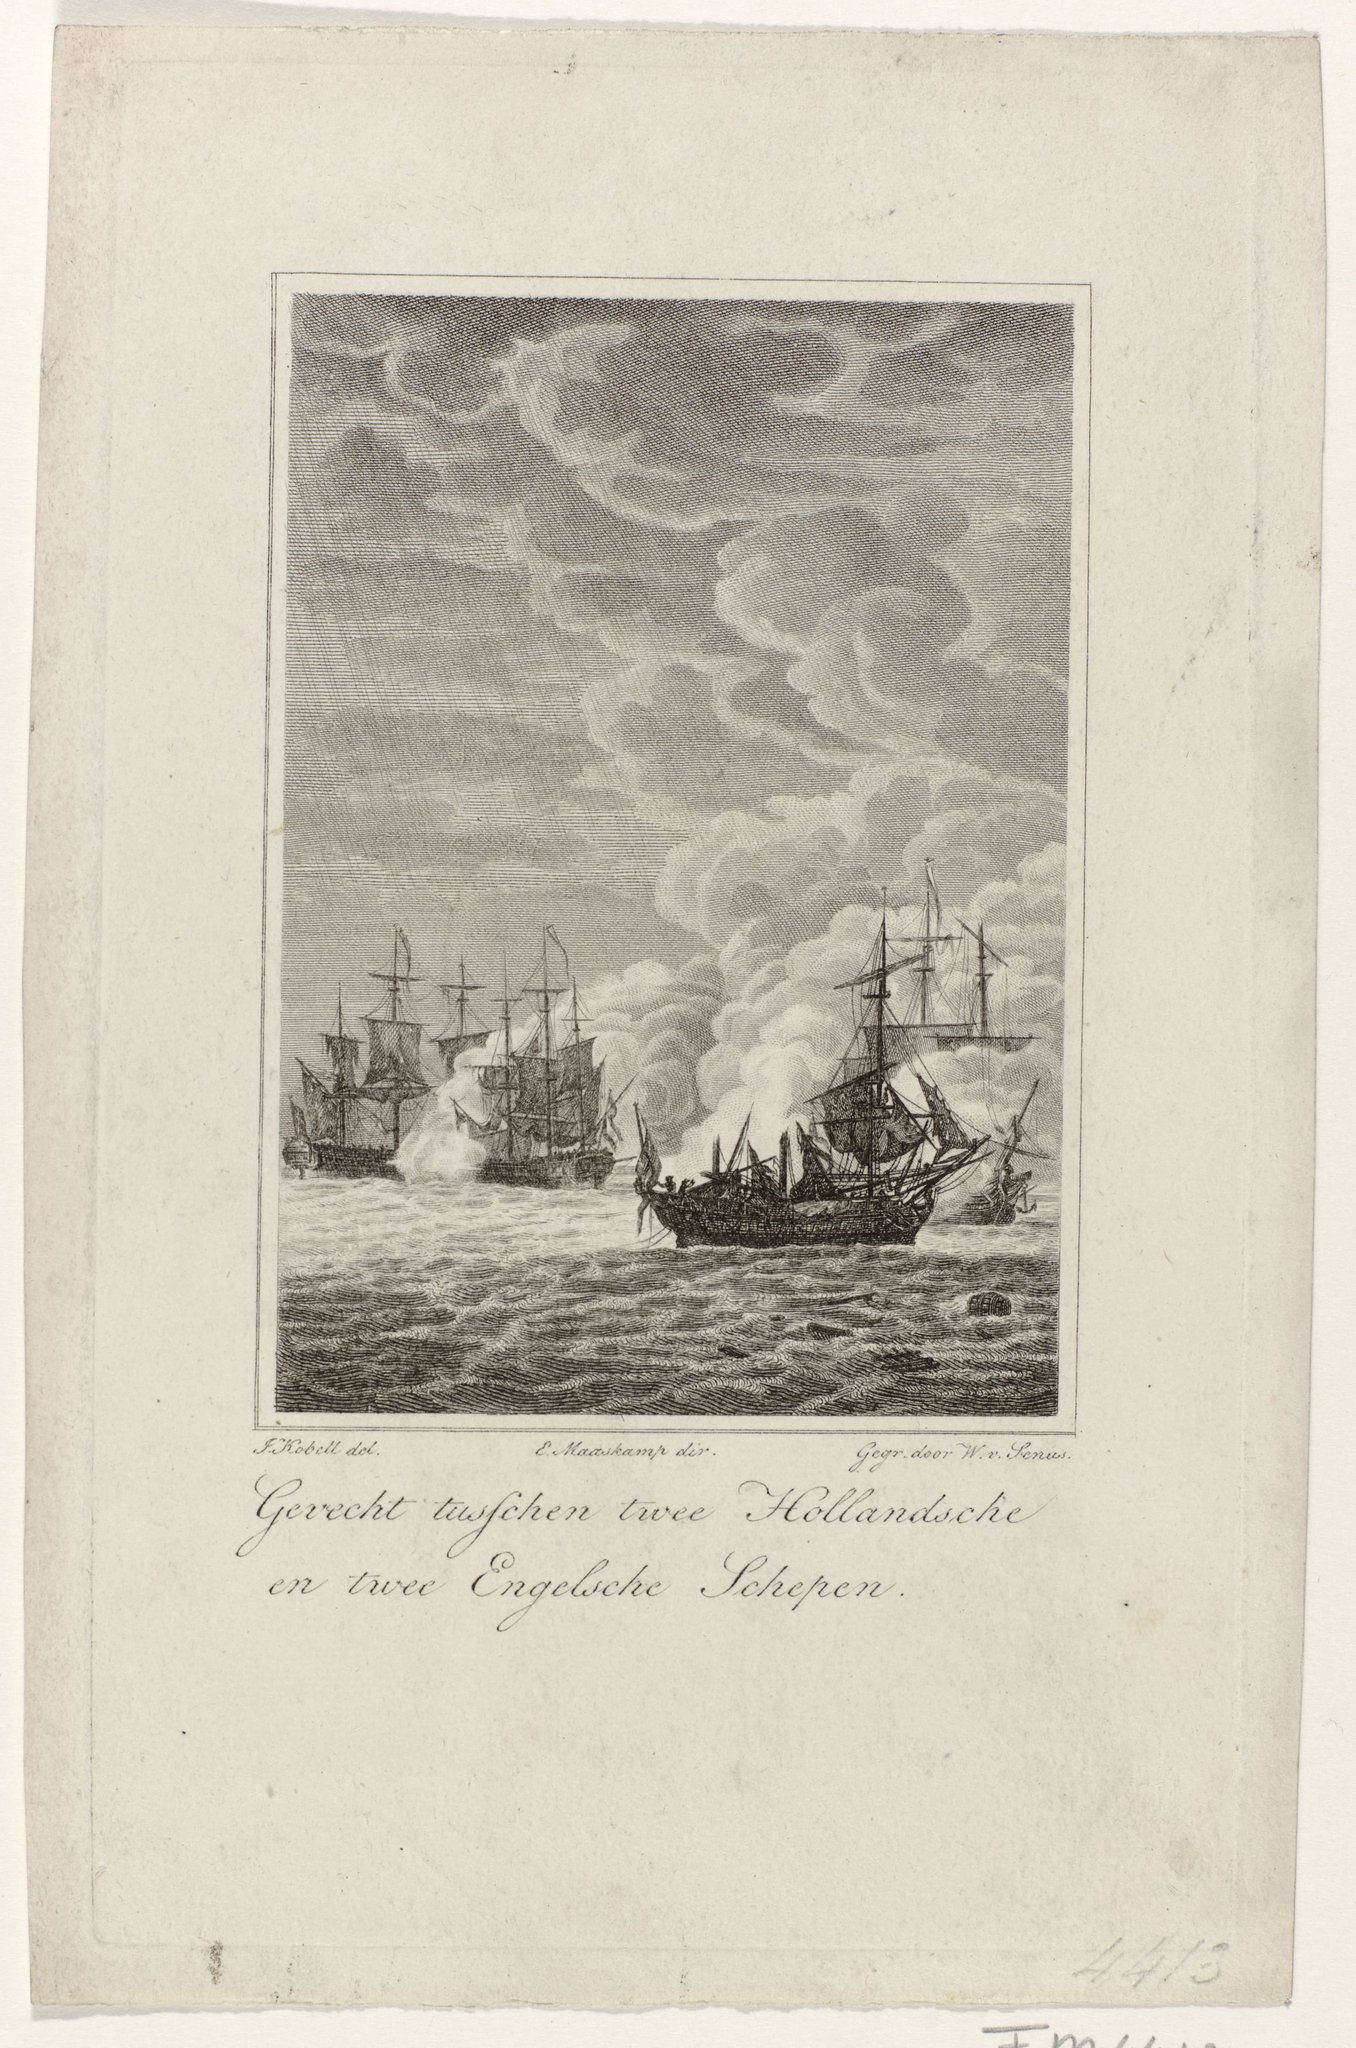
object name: print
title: Gevecht tusschen twee Hollandsche en twee Engelsche Schepen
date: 1819-1821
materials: paper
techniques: engraving, etching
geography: netherlands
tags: dordrecht, the hague, naval officer, pieter melvill van carnbee, rotterdam, gerardus oorthuys, battle (+ naval force)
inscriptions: collector's mark: Lugt 2228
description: Gebaseerd op de prent van Mathias de Sallieth (FMH 4405a) naar ontwerp van Jan Kobell (I). Gebruikt als illustratie in: Martinus Stuart. Vaderlandsche historie, vervattende de geschiedenissen der Vereenigde Nederlanden. Amsterdam: Evert Maaskamp, 1821-1826.